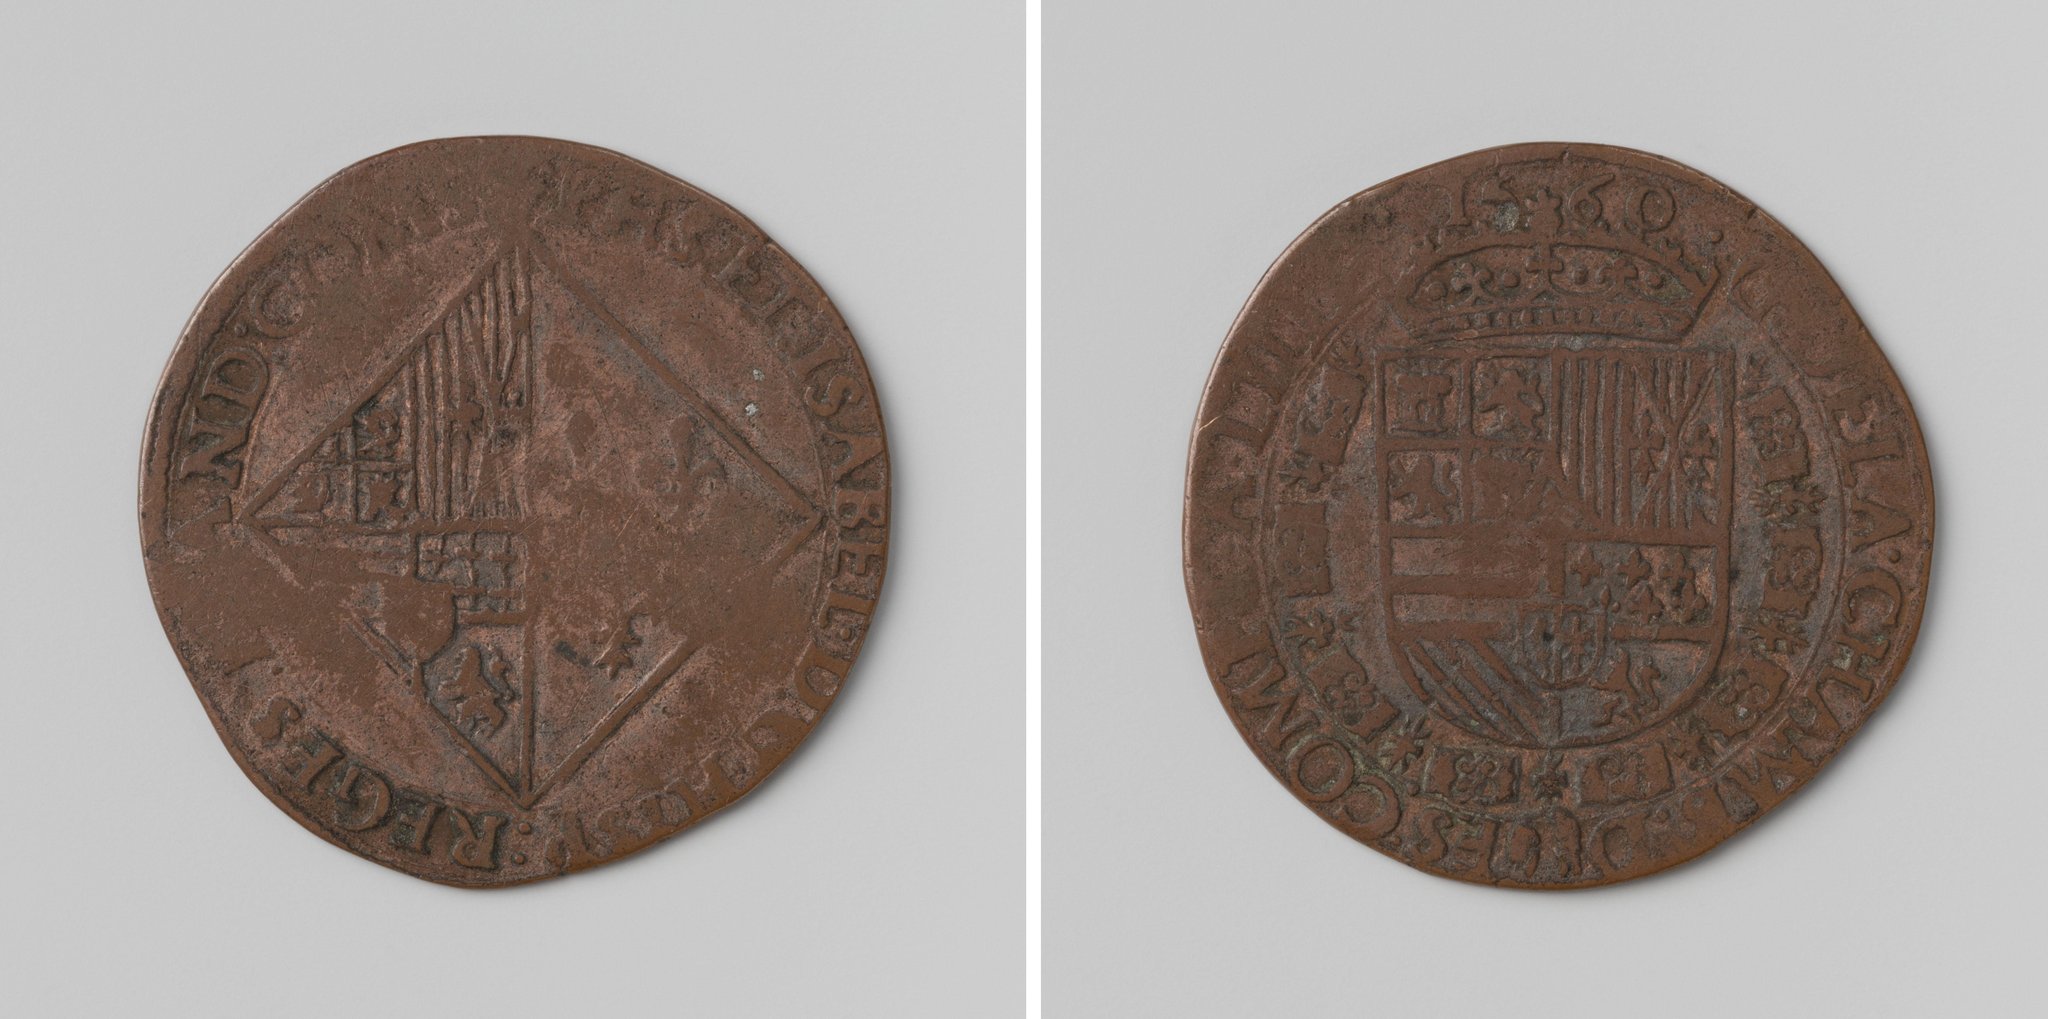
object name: jeton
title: Filips II en Isabella, koning en koningin van Spanje, rekenpenning van de rekenkamer van Vlaanderen te Rijssel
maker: Anonymous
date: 1560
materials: copper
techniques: striking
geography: flanders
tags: philip ii of spain, lille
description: Koperen penning. Voorzijde: ruitvormig wapenschild binnen omschrift. Keerzijde: gekroond wapenschild omhangen met orde van Gulden Vlies binnen omschrift